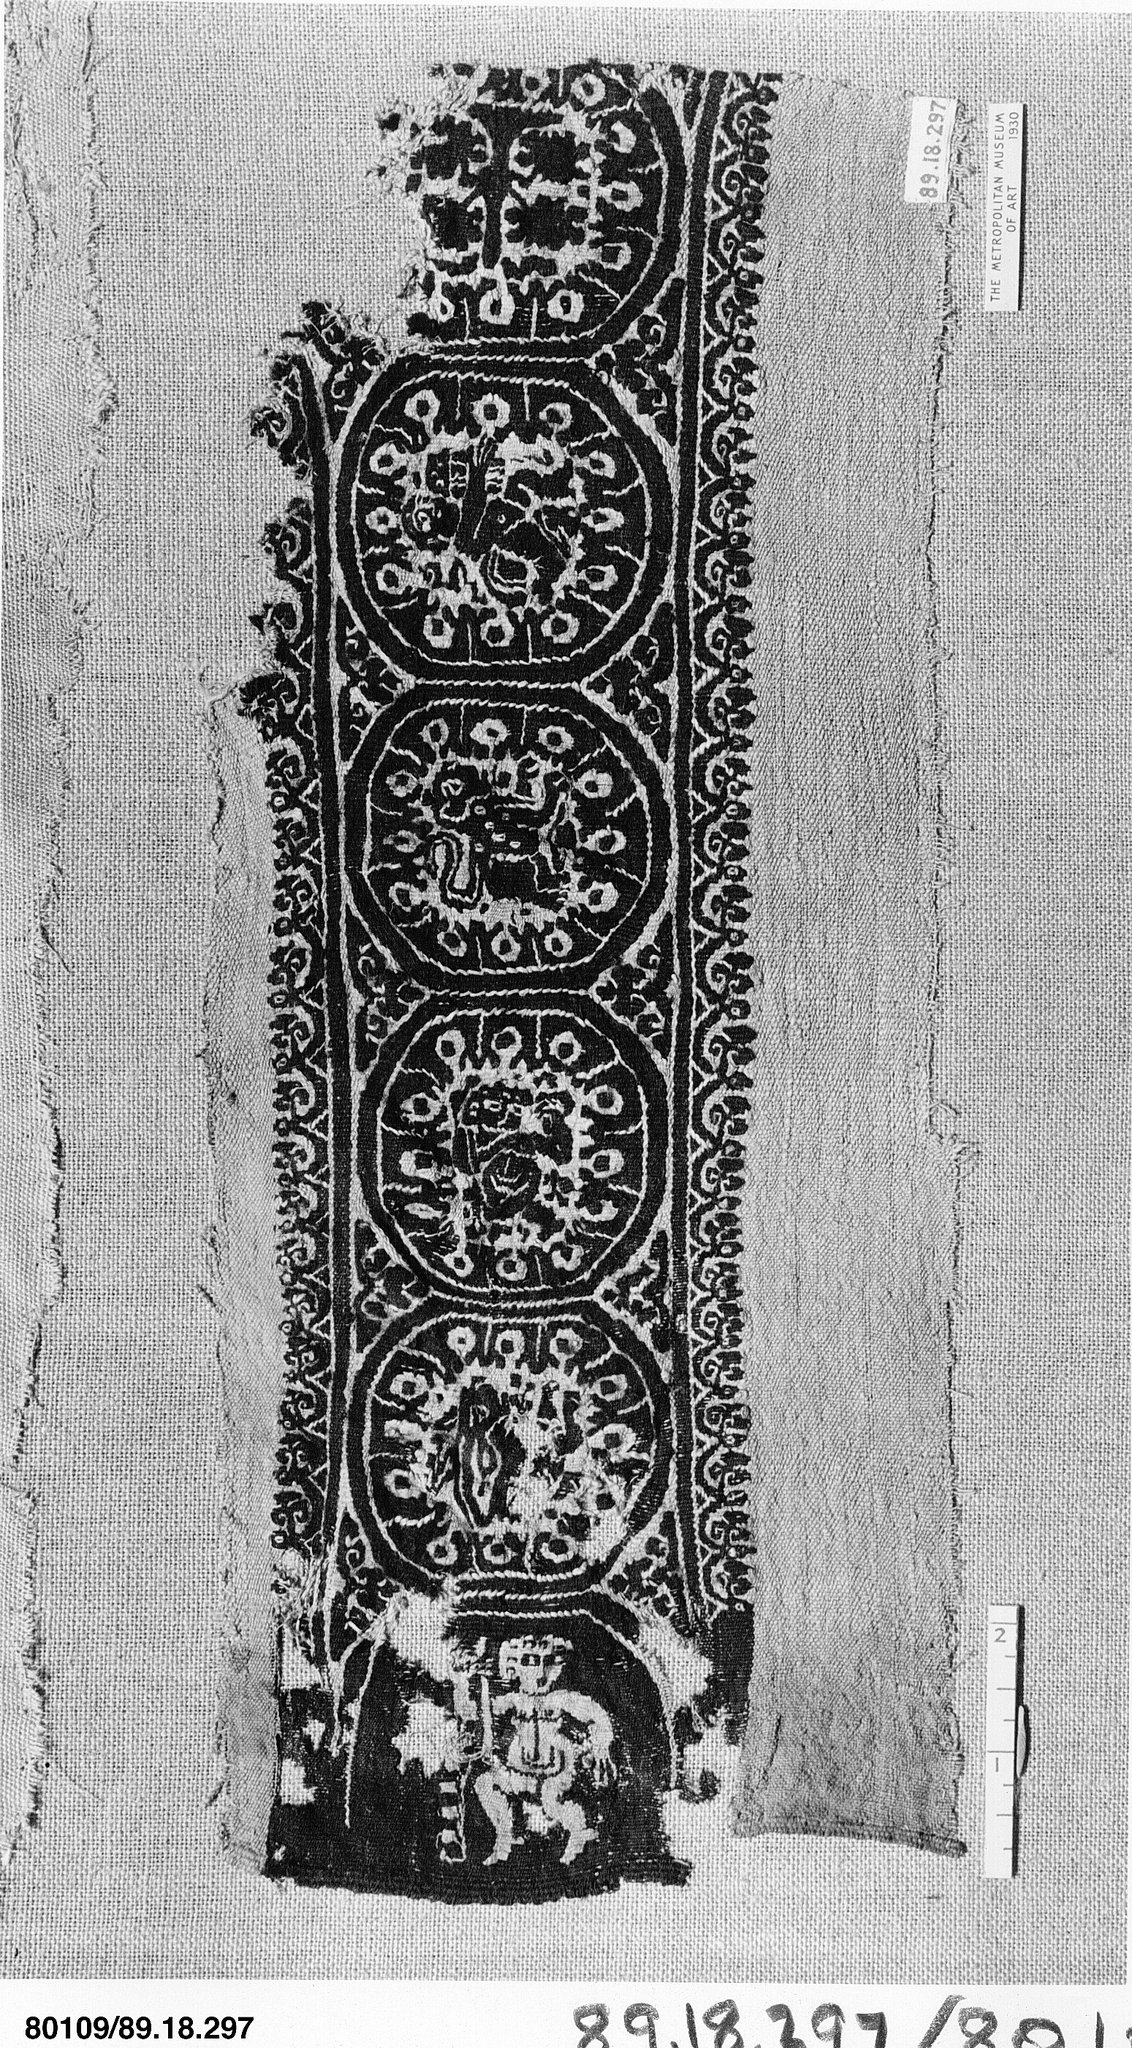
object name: textile fragment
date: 201-400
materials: linen, wool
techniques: weave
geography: egypt